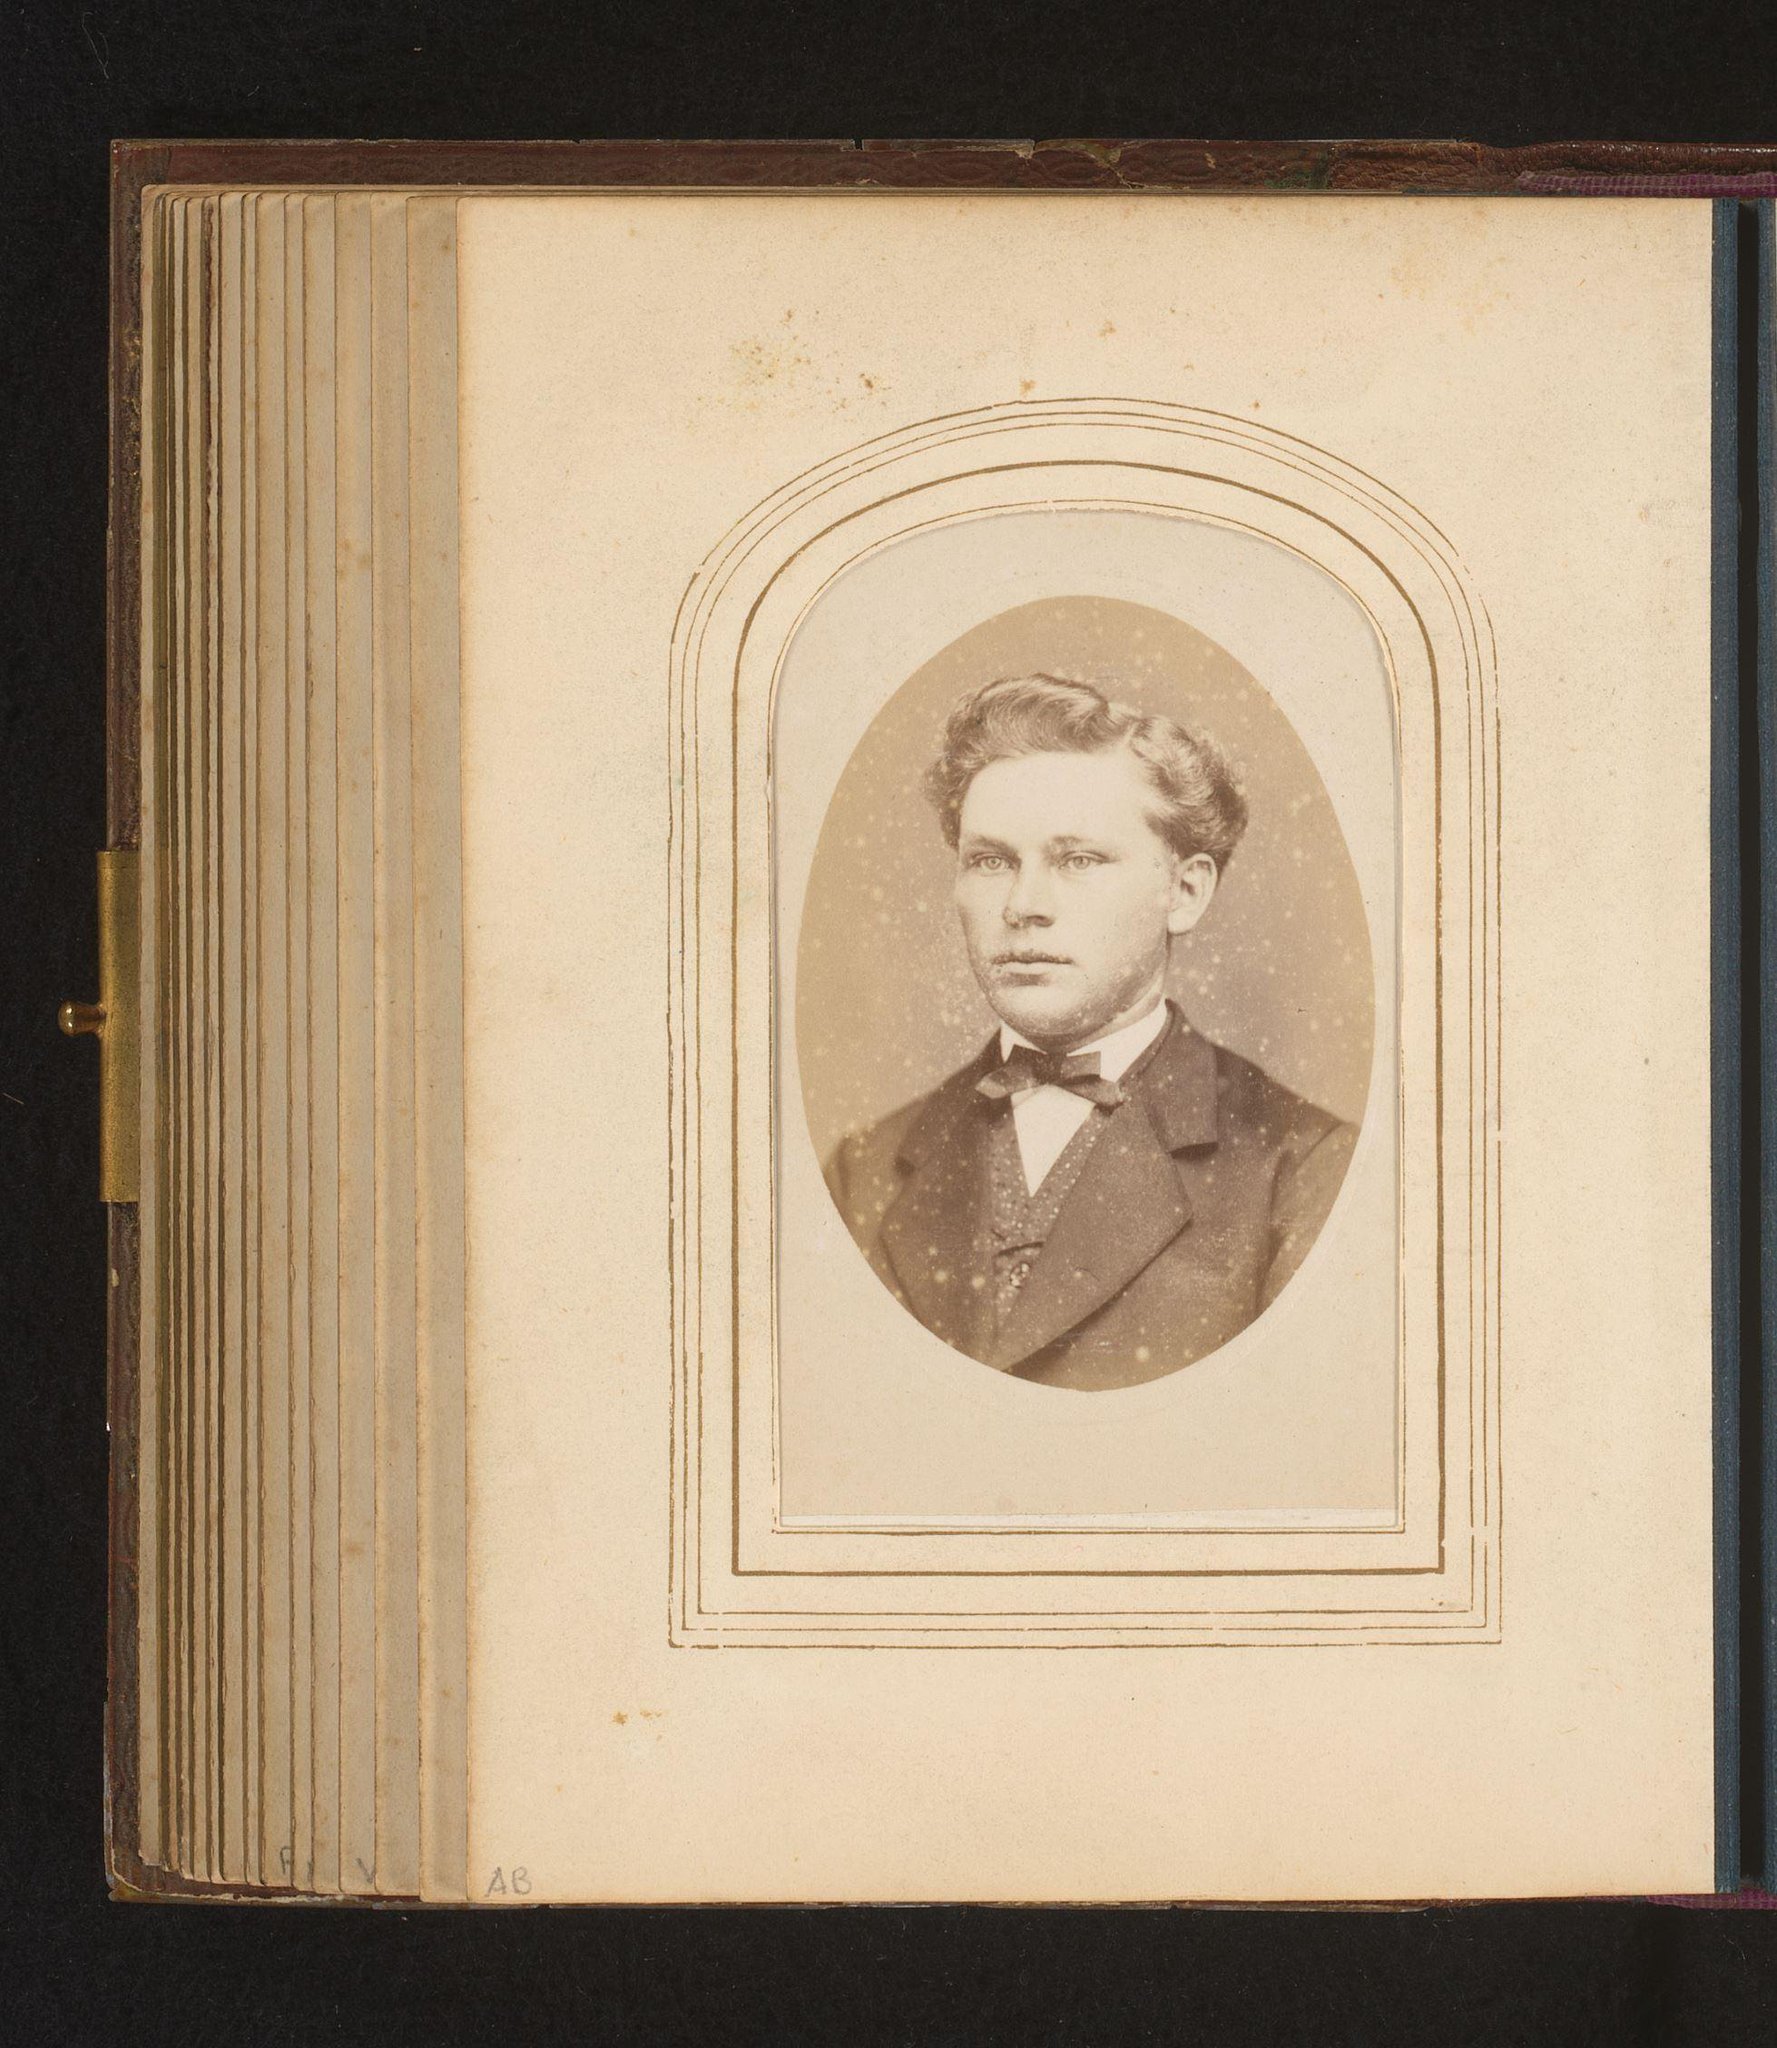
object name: photograph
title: Portret van een jonge man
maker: benjamin sanders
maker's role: fotograaf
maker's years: 1841-1889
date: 1875-1879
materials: cardboard, photographic support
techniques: albumen print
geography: groningen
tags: historical persons, youth, adolescent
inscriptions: inscription: ‘B. Sanders/ Photographe/ Groningen/ Nieuwe Ebbingestraat./ Deze Portretten kunnen/ steeds nabesteld worden.’